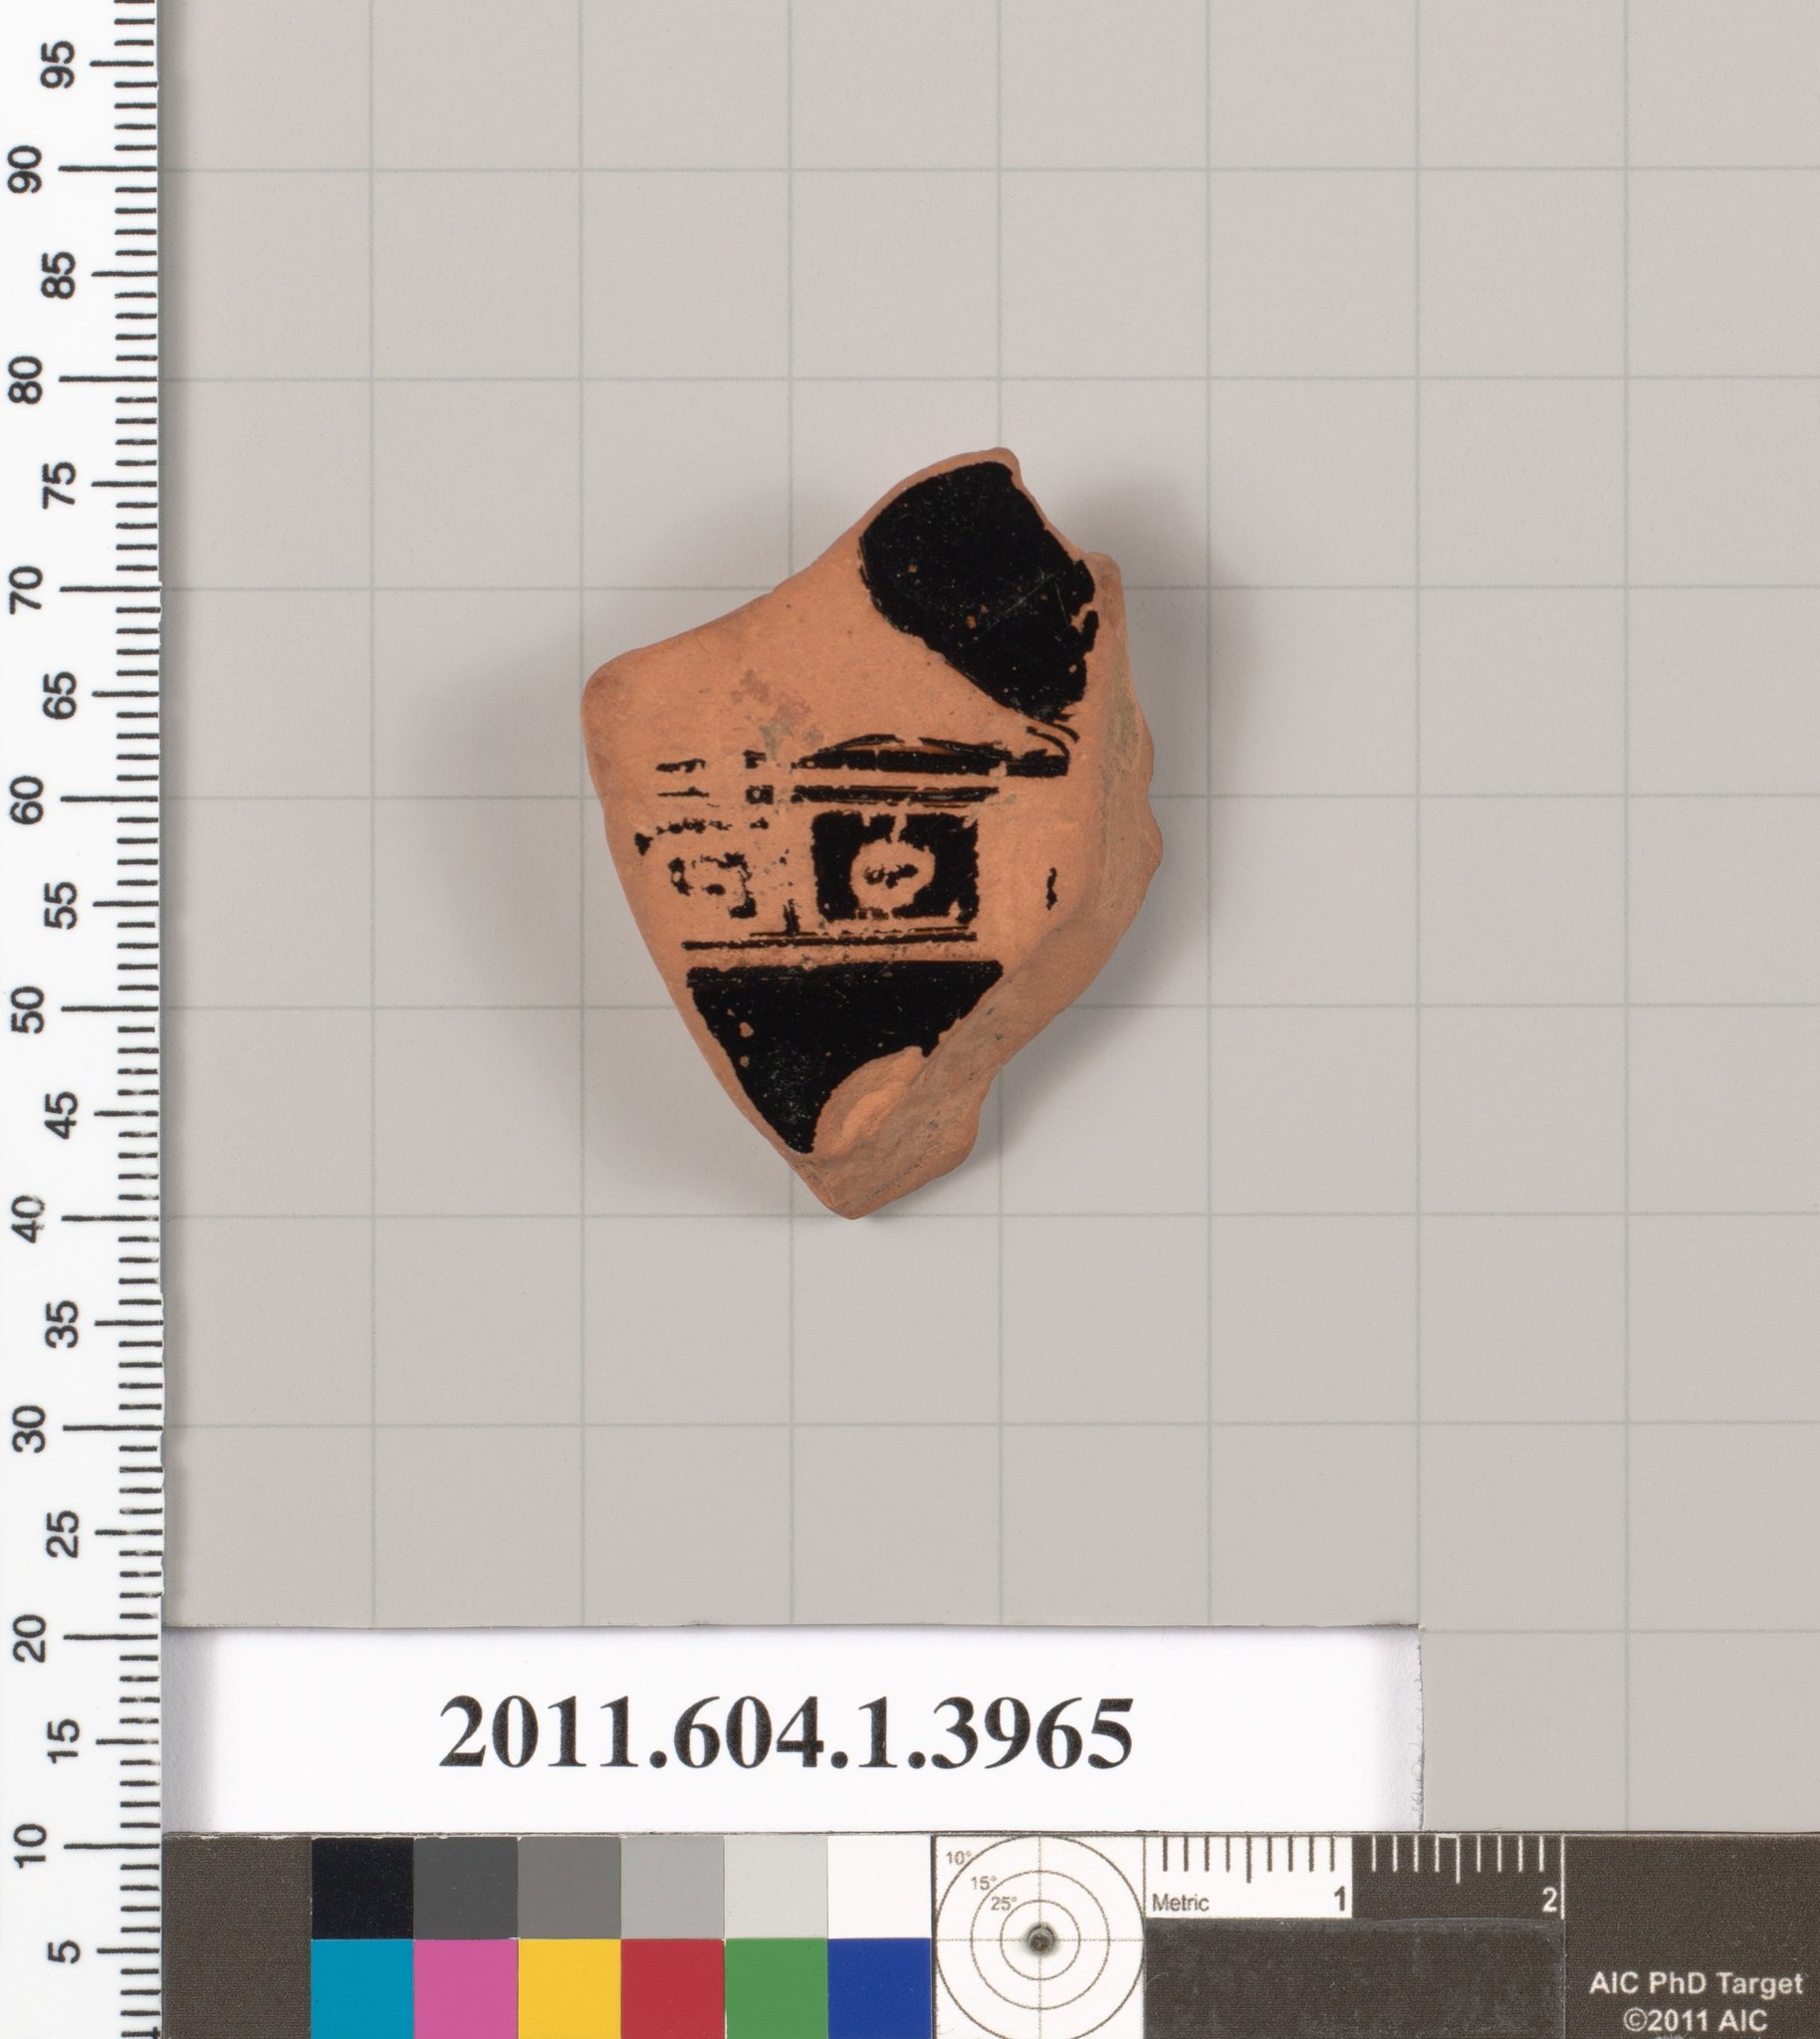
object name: kylix fragment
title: Terracotta fragment of a kylix (drinking cup)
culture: greek, attic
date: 490-470 BCE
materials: terracotta